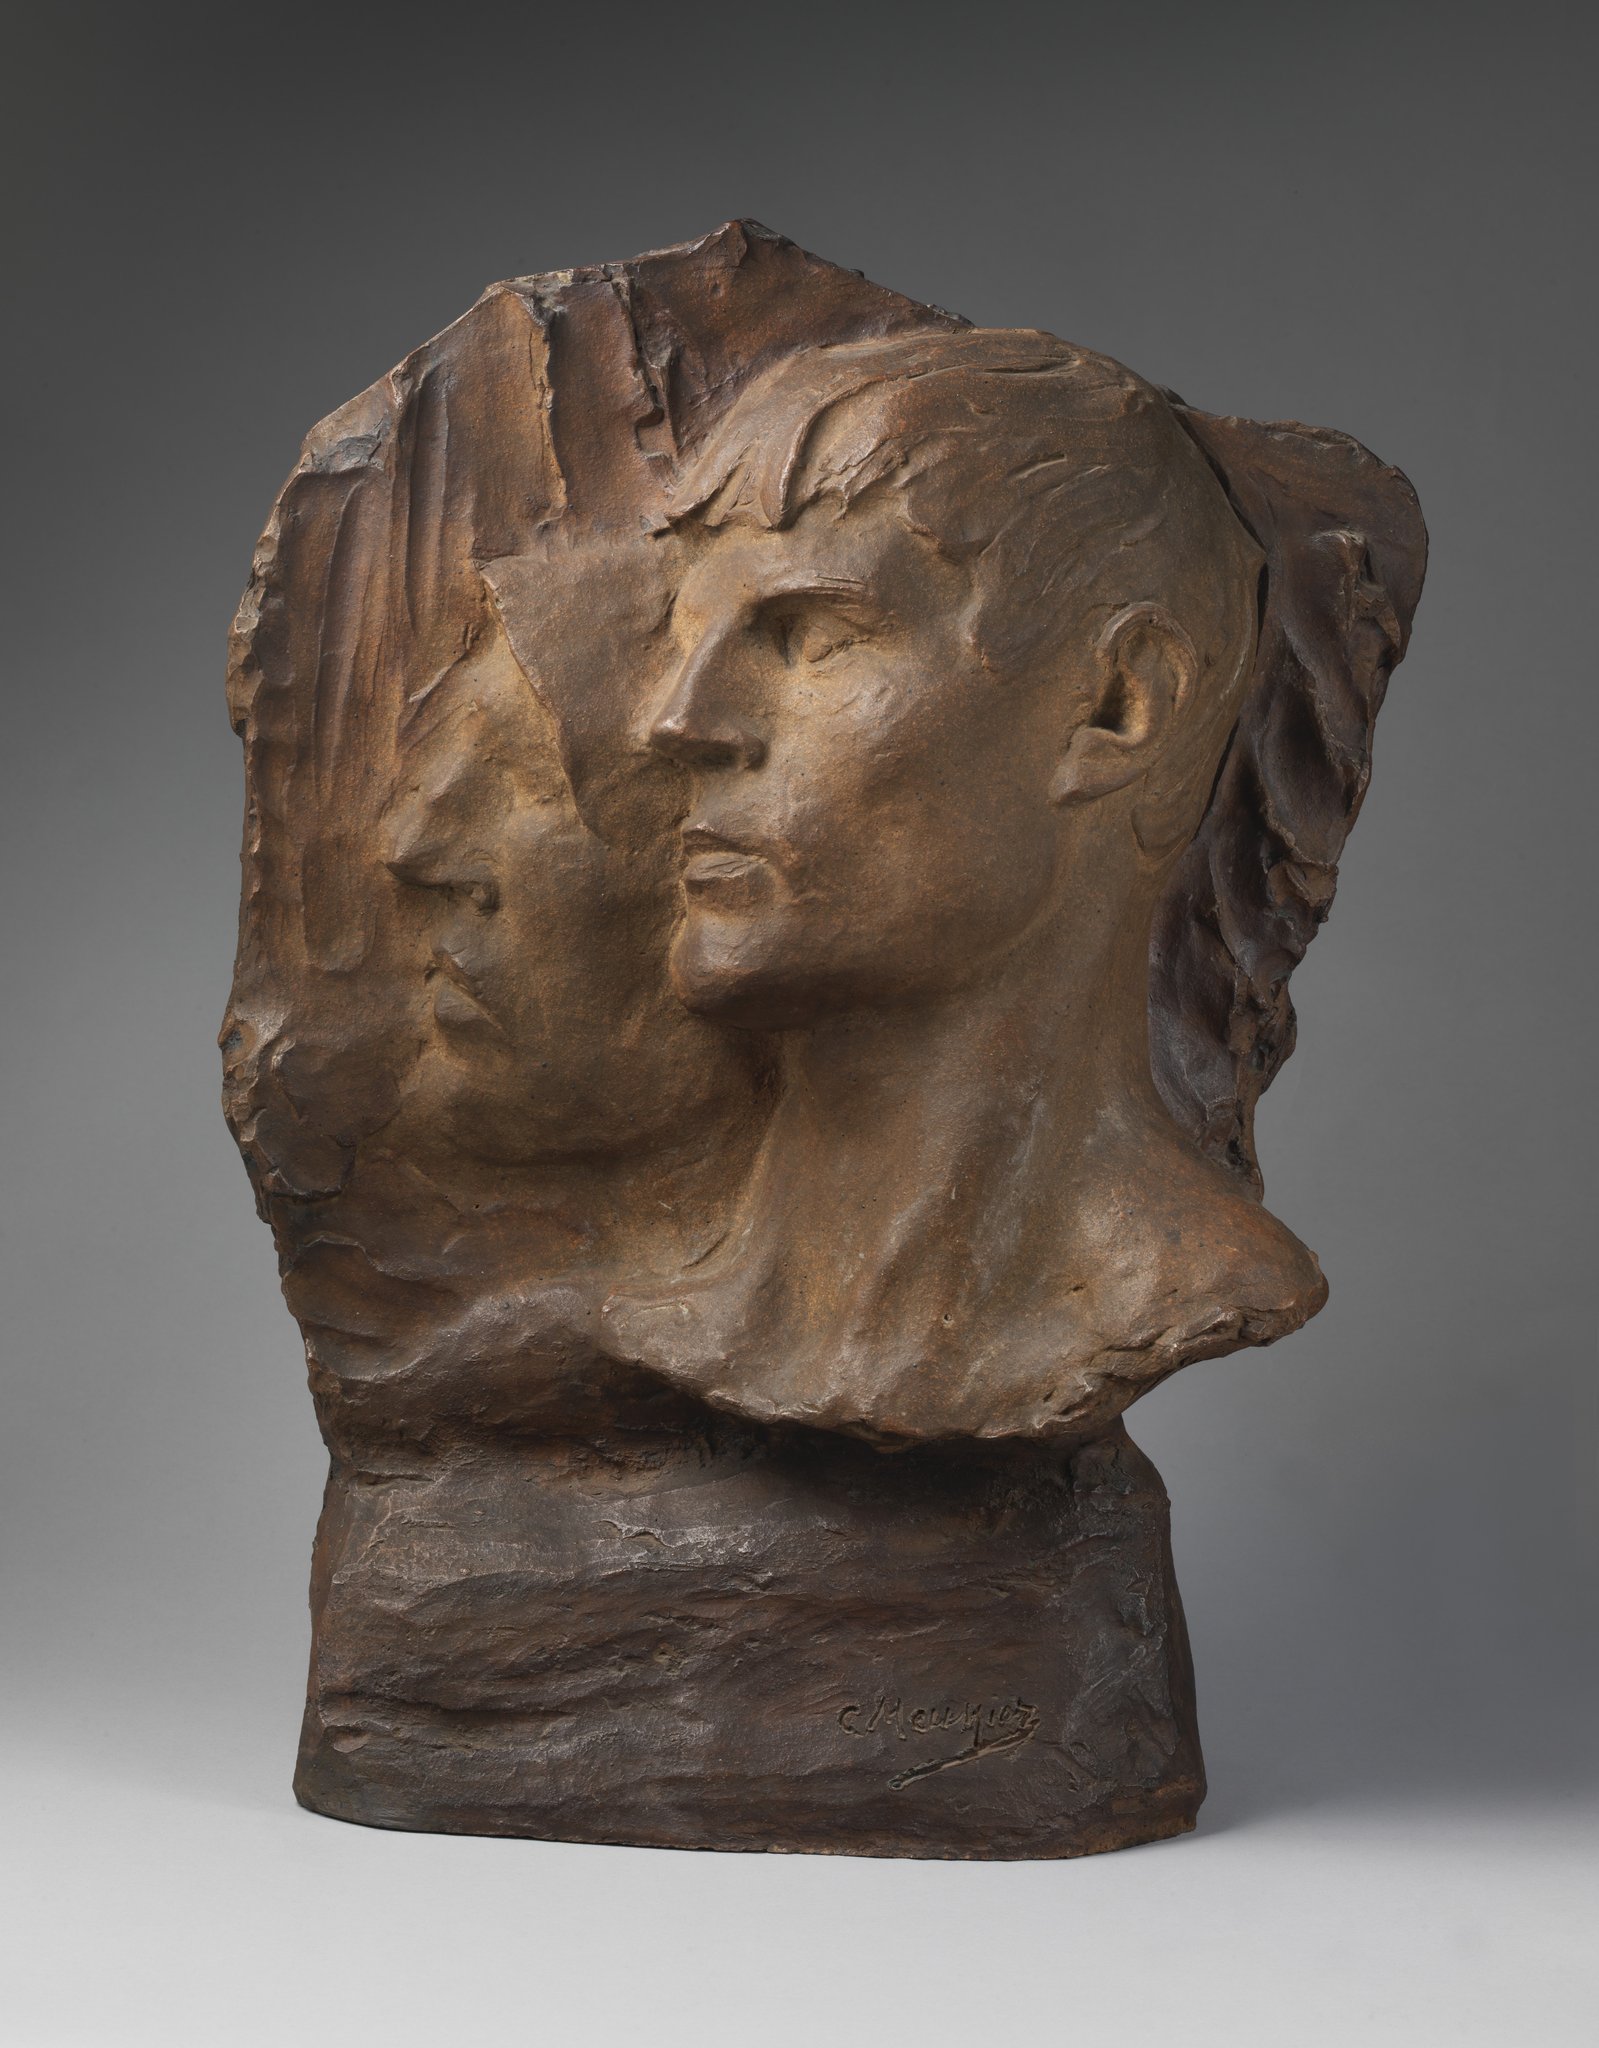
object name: relief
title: Puddlers in Profile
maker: constantin meunier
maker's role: artist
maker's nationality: belgian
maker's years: 1831-1905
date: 1900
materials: stoneware